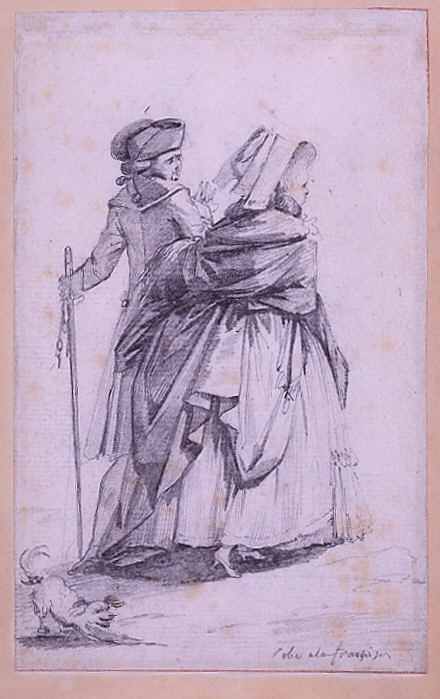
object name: drawing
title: Strolling Couple with a Dog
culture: french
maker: gandolphe jean emile francis moutier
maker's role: artist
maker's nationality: french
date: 1820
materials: graphite, paper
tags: men,women,dogs